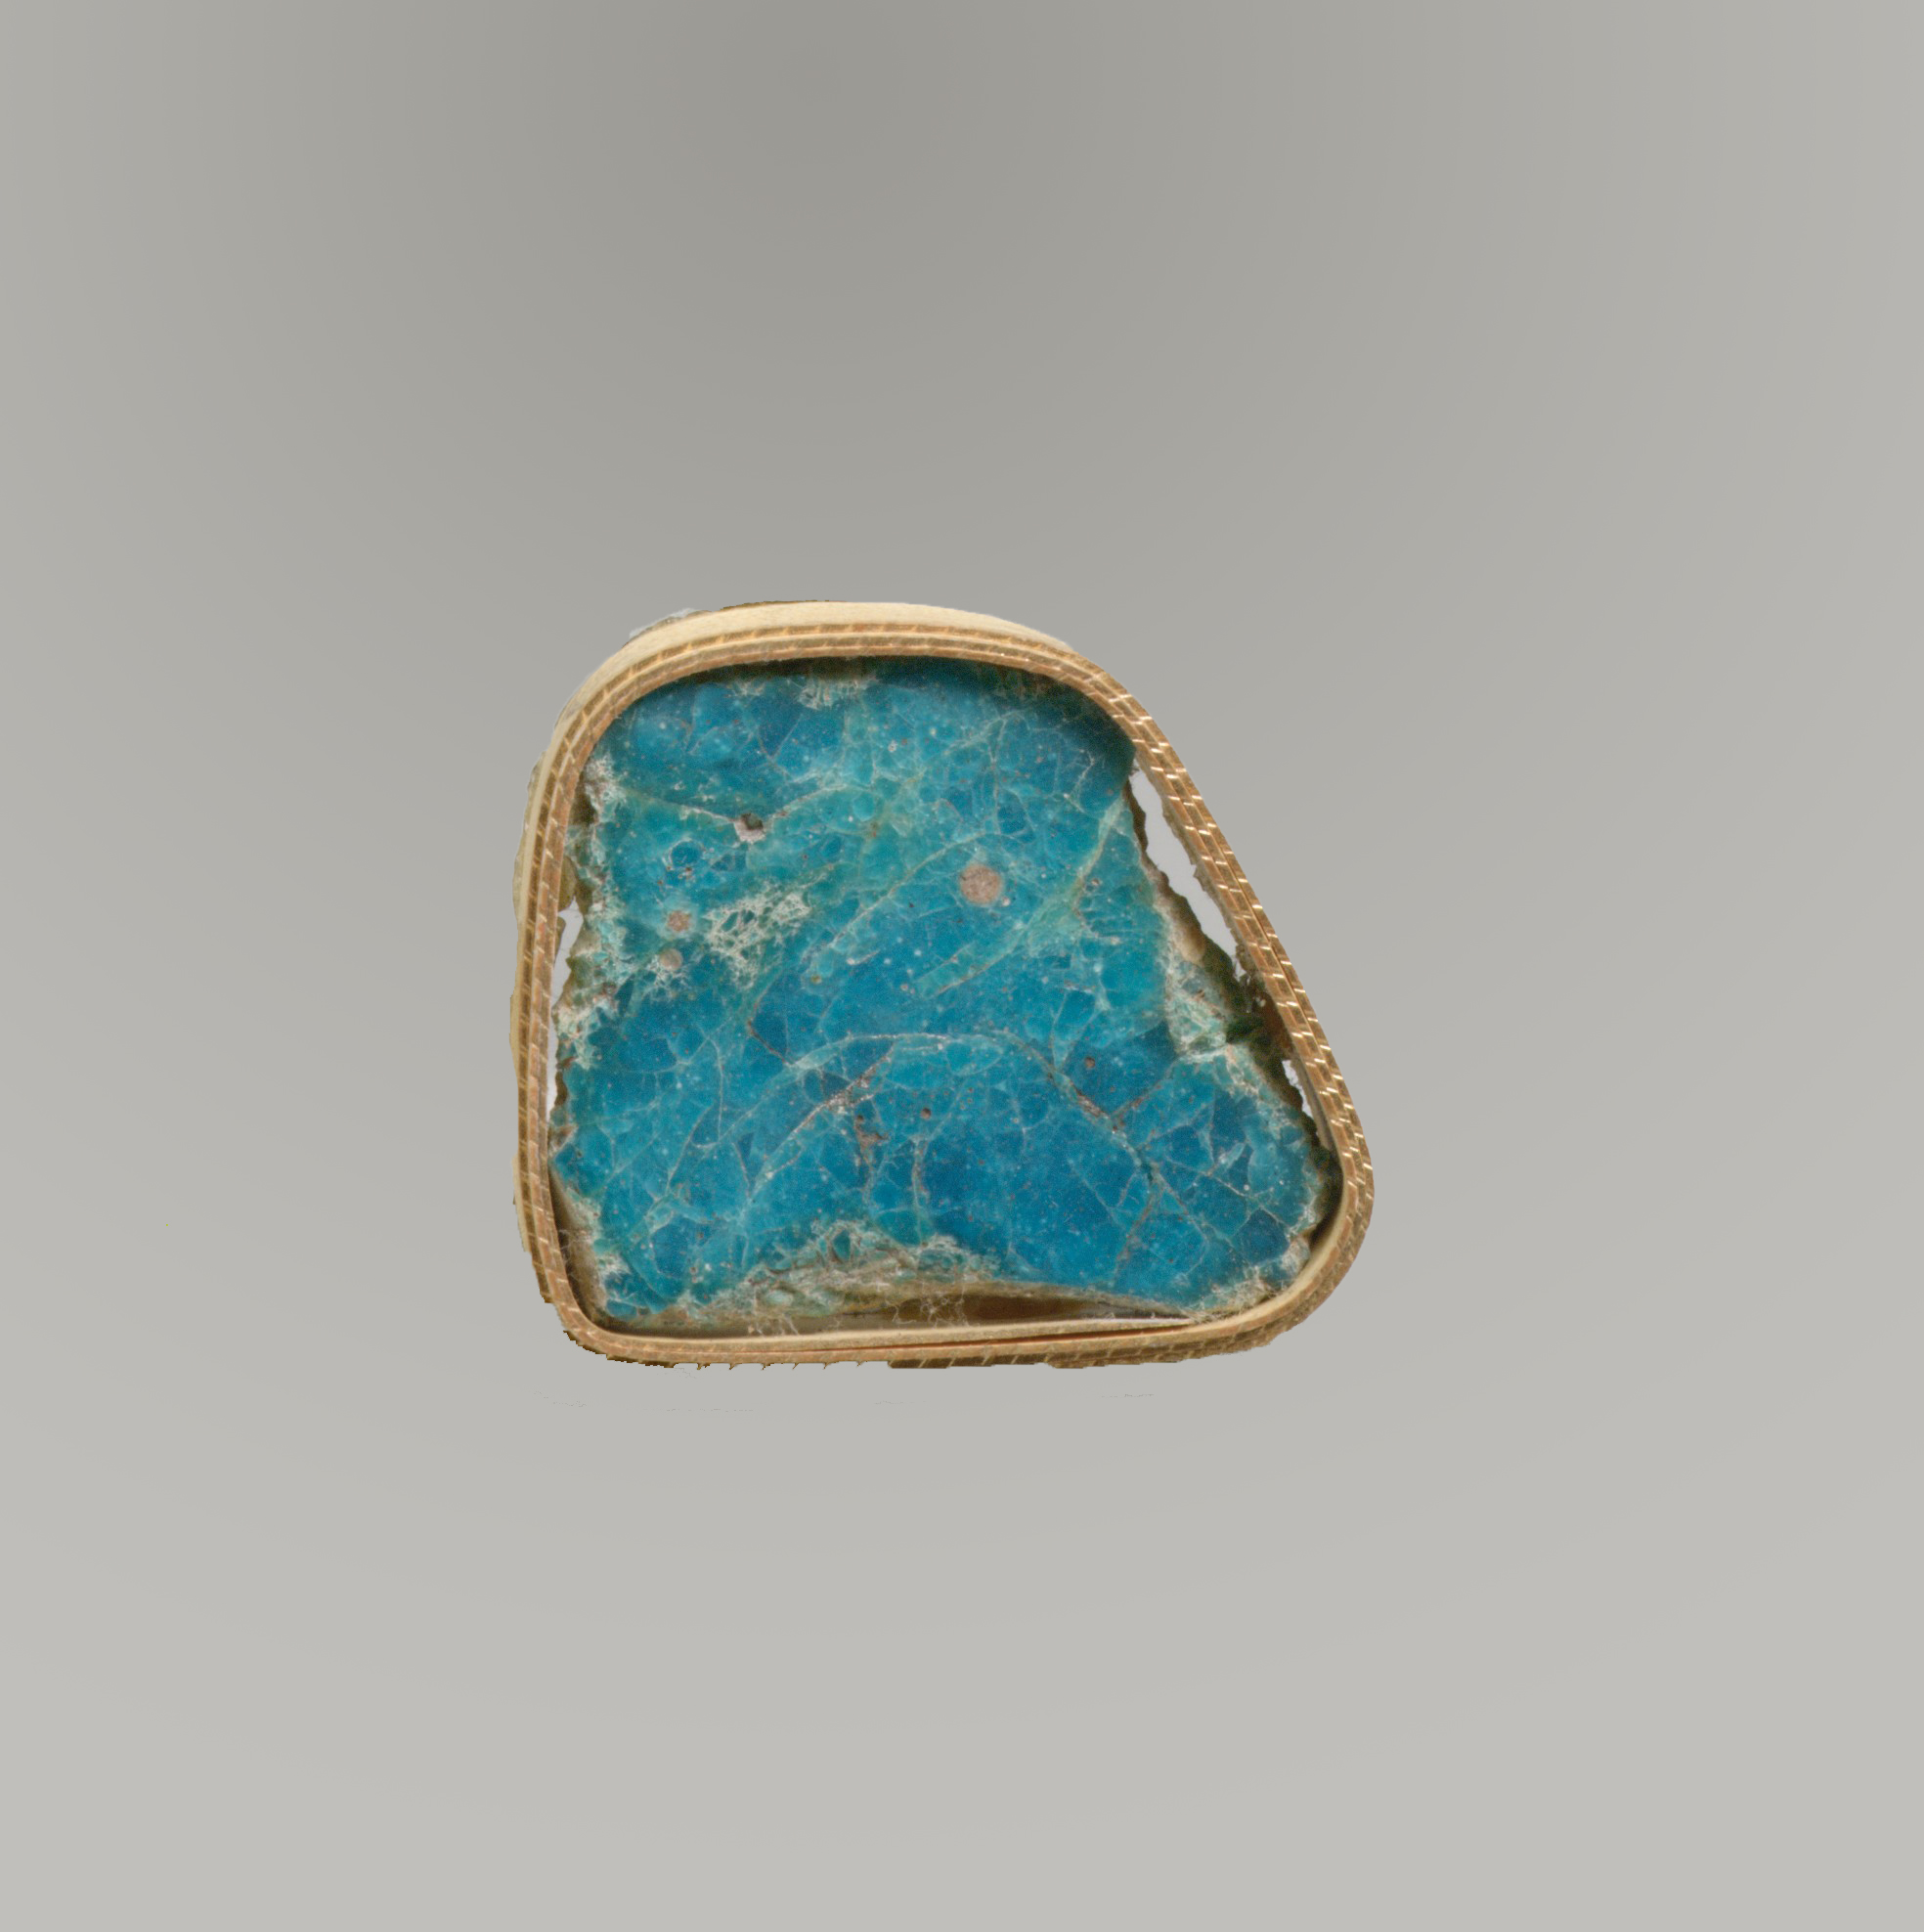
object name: fragment, monchrome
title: Glass monochrome fragment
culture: roman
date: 34 BCE-33 CE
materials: glass